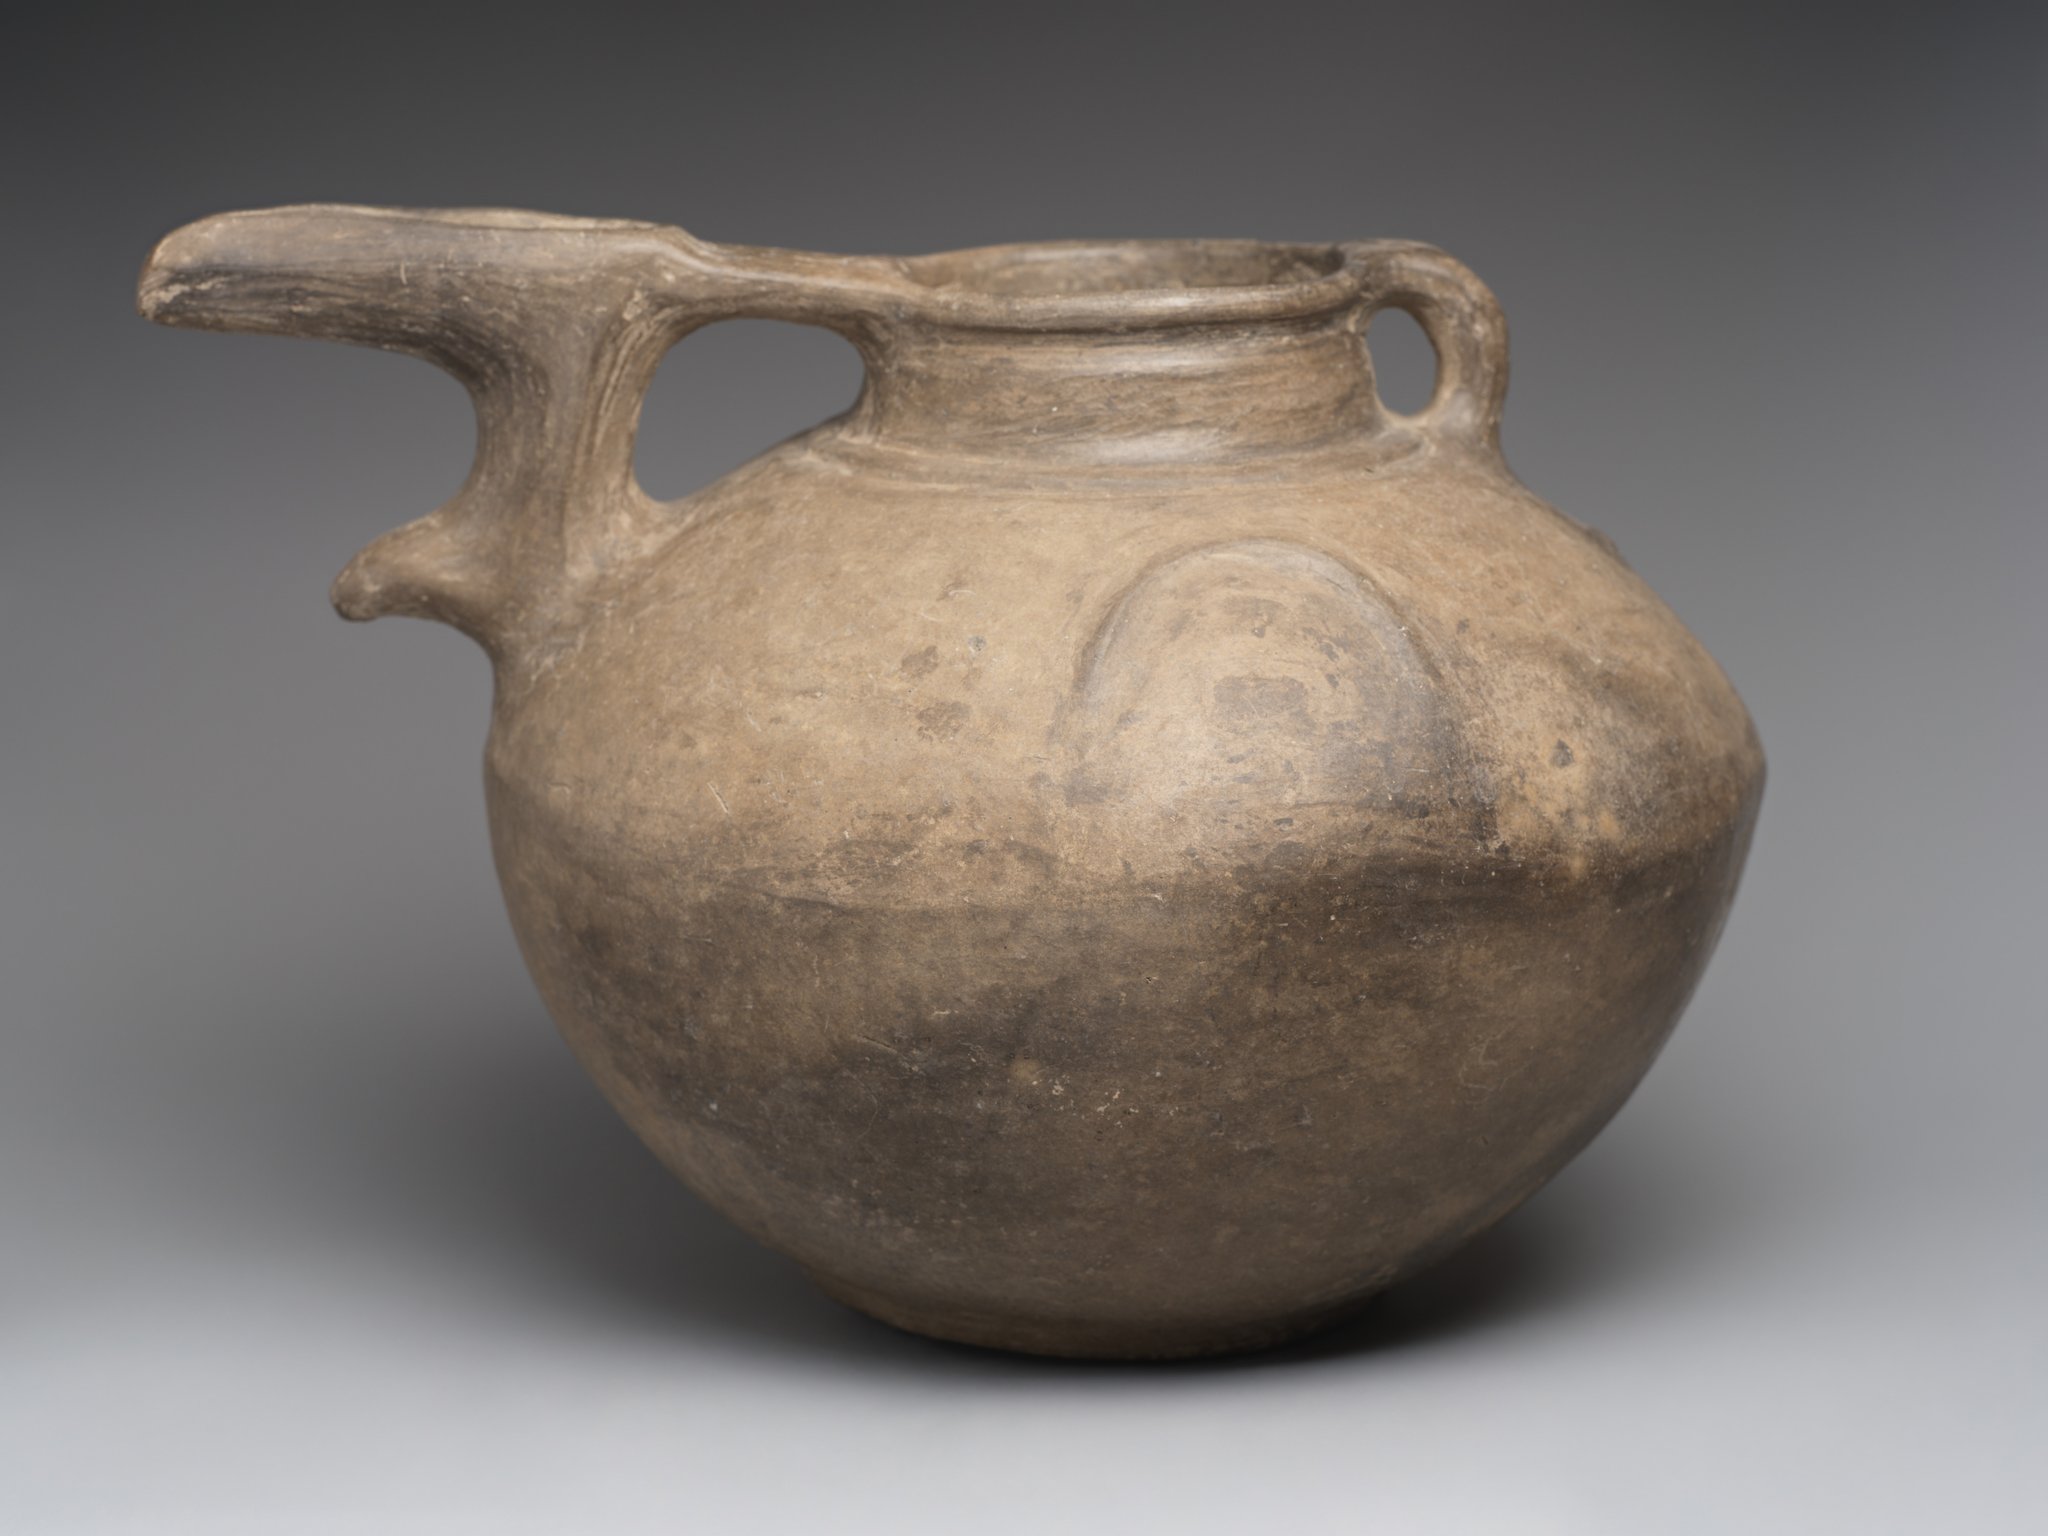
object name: pitcher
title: Bridge-spouted pitcher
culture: iranian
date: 1000-801 BCE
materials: ceramic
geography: iran